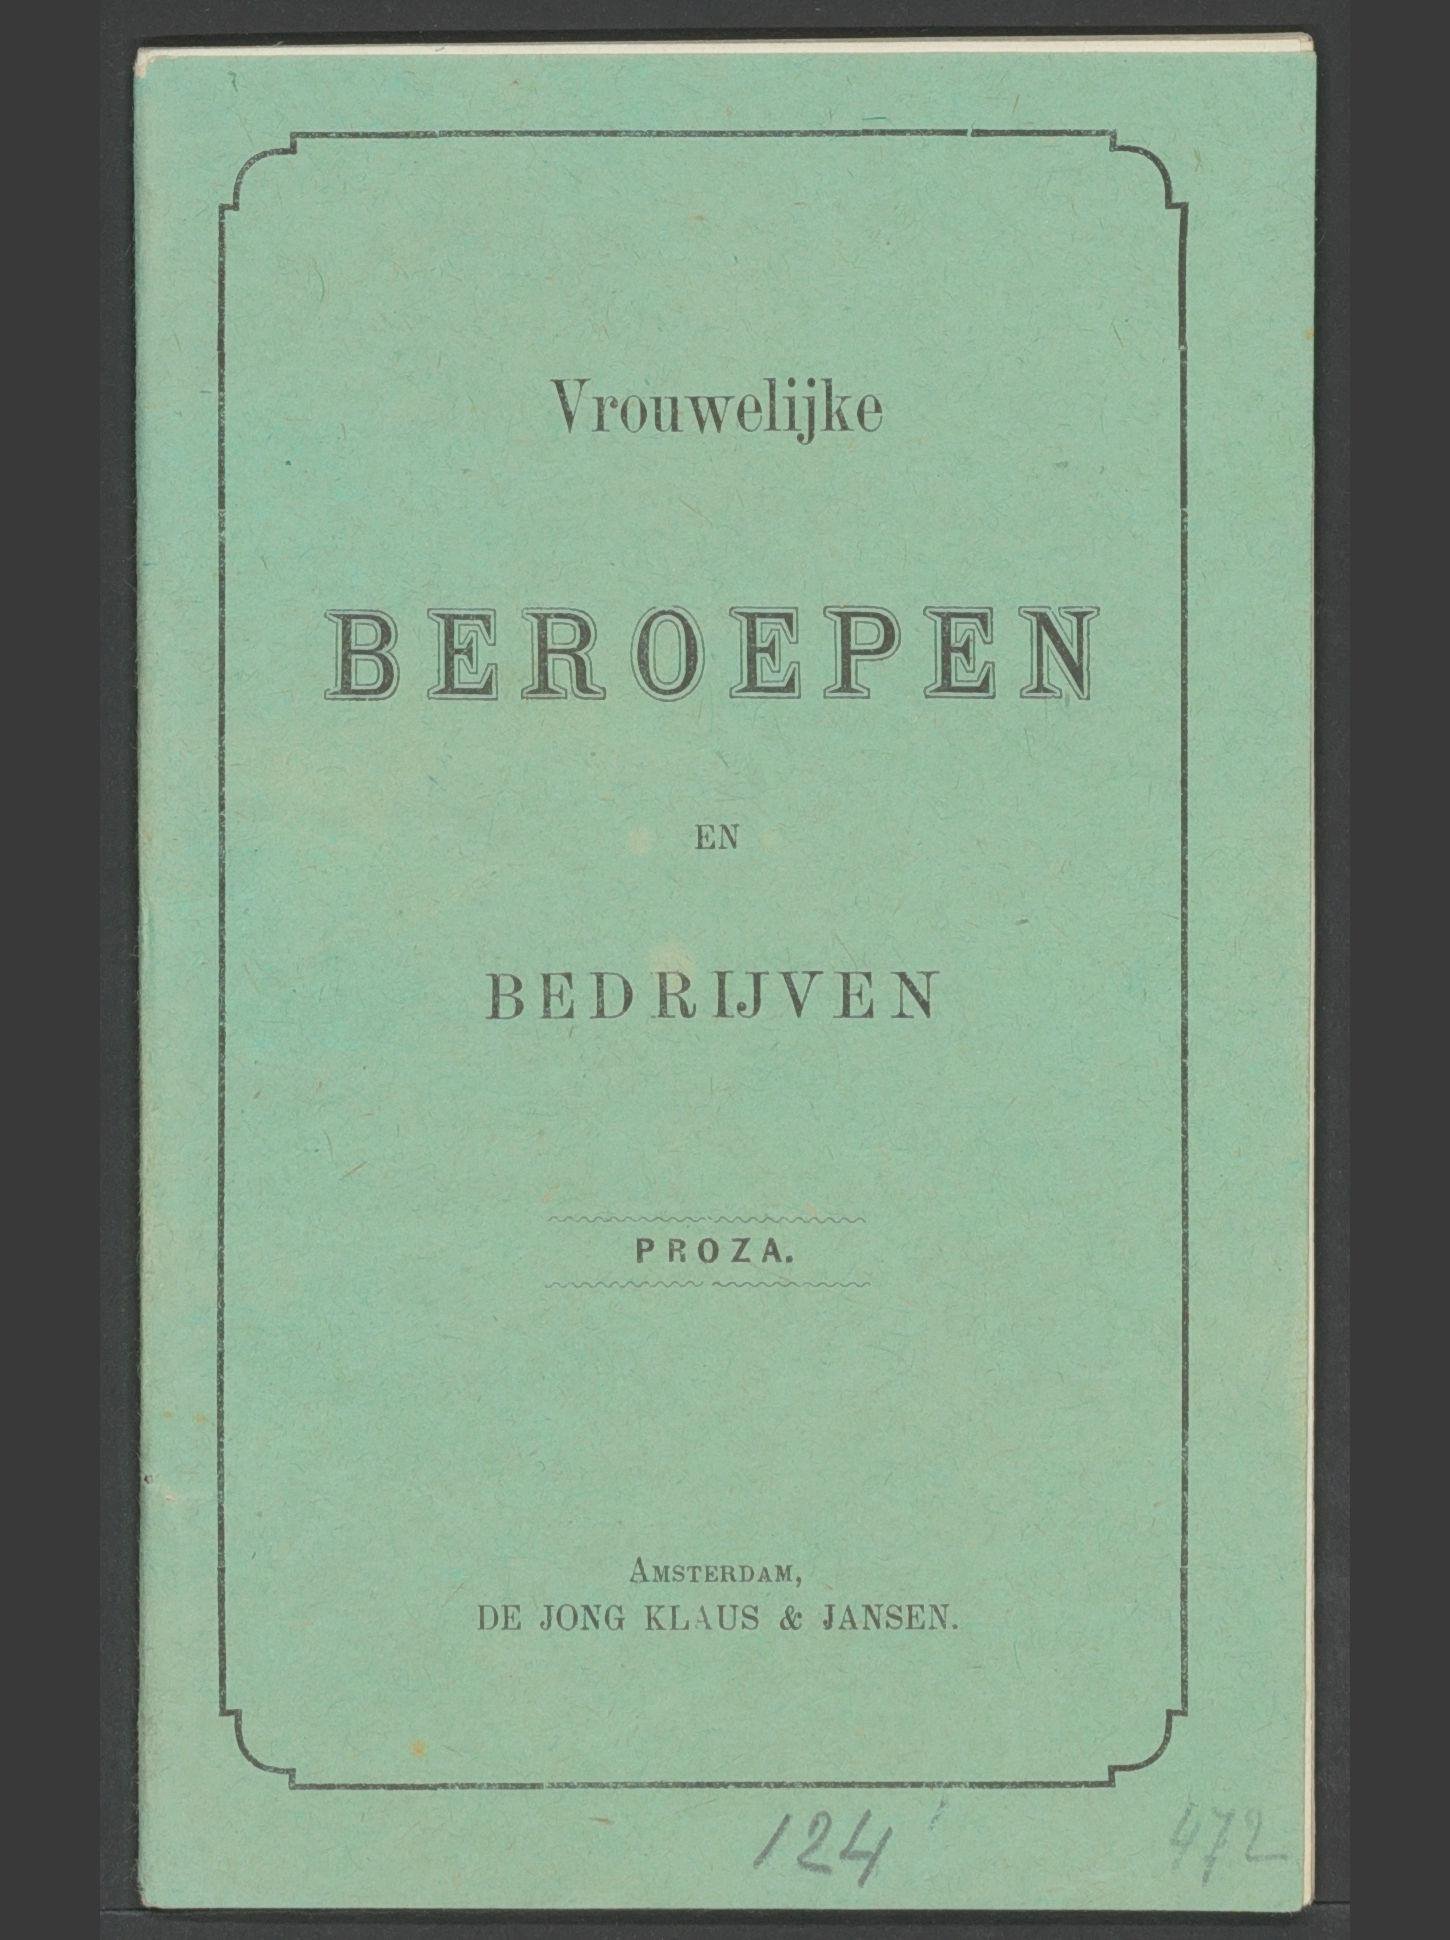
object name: print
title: Vrouwelijke Beroepen en Bedrijven / Proza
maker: Anonymous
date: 1850-1860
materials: paper, watercolor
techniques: hand coloring, letterpress printing, lithograph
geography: amsterdam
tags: lace-making, peat-cutting (+ women (labourers)), spinning (manufacture of yarn) (+ women (labourers)), flax (material ~ textile and clothing industry) (+ women (labourers)), merchant, salesman - bb - women engaged in trade and commerce, laundering, (other forms of) needlework, e.g.: crocheting, knitting, embroidering, milkmaid, home sewing; repair of clothes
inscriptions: collector's mark, collector's mark: Lugt 1641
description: Boekje van zestien bladzijden met acht illustraties van vrouwelijke beroepen aangeduid als: de vlasspinster, de borduurster, de mosselvrouw, de wasvrouw, de modemaakster, de kantwerkster (ingekleurd), de melkvrouw en de turftonster. Met begeleidende tekst. Gebonden in een groene omslag. Onderwerpsrubrieken binnen de Atlas Zeden en Gewoonten: Beroep en bedrijf. Vrouwelijk beroep en bedrijf: Varia en kinderprenten.